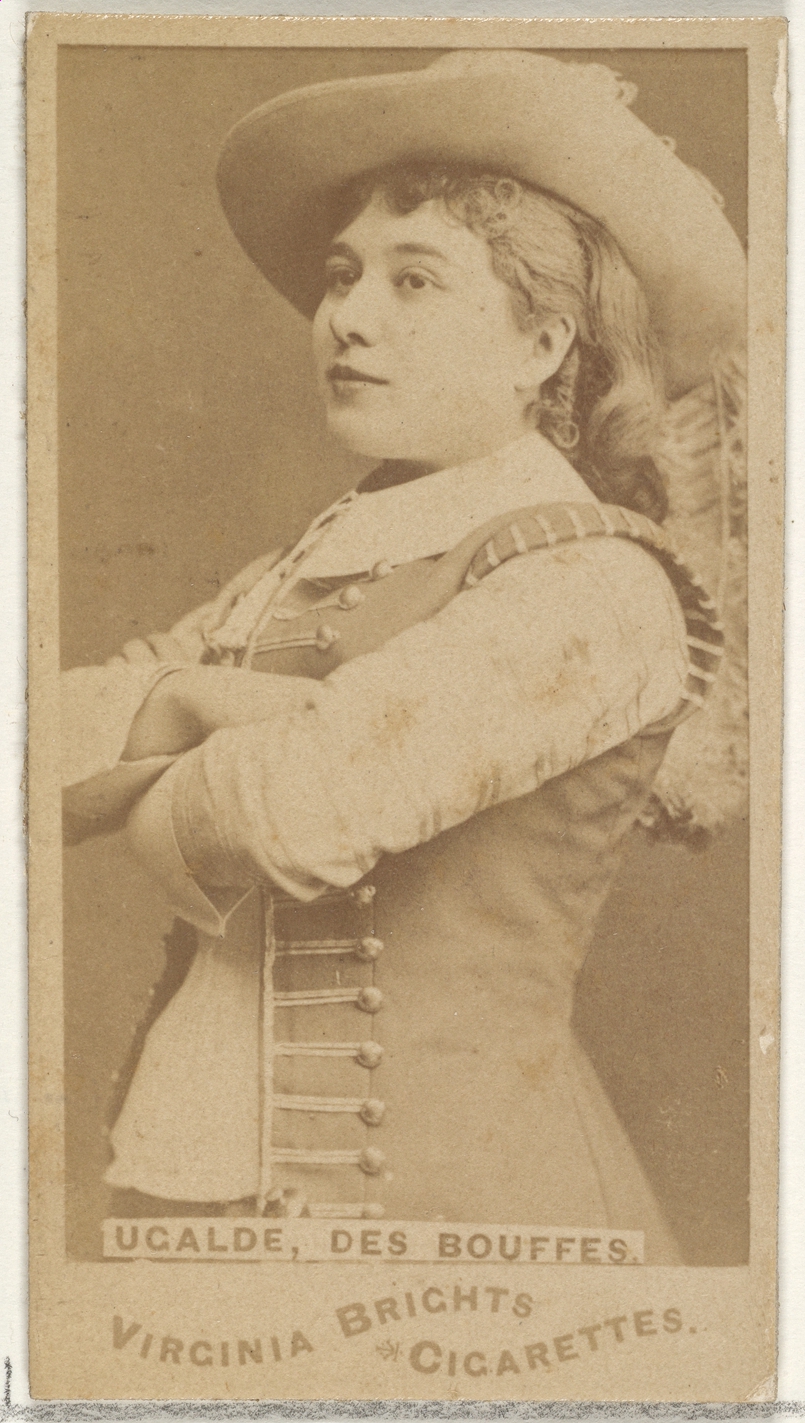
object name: photograph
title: Ugalde, Des Bouffes, from the Actors and Actresses series (N45, Type 1) for Virginia Brights Cigarettes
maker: allen & ginter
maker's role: publisher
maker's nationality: american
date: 1888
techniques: albumen silver print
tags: portraits,women,actresses